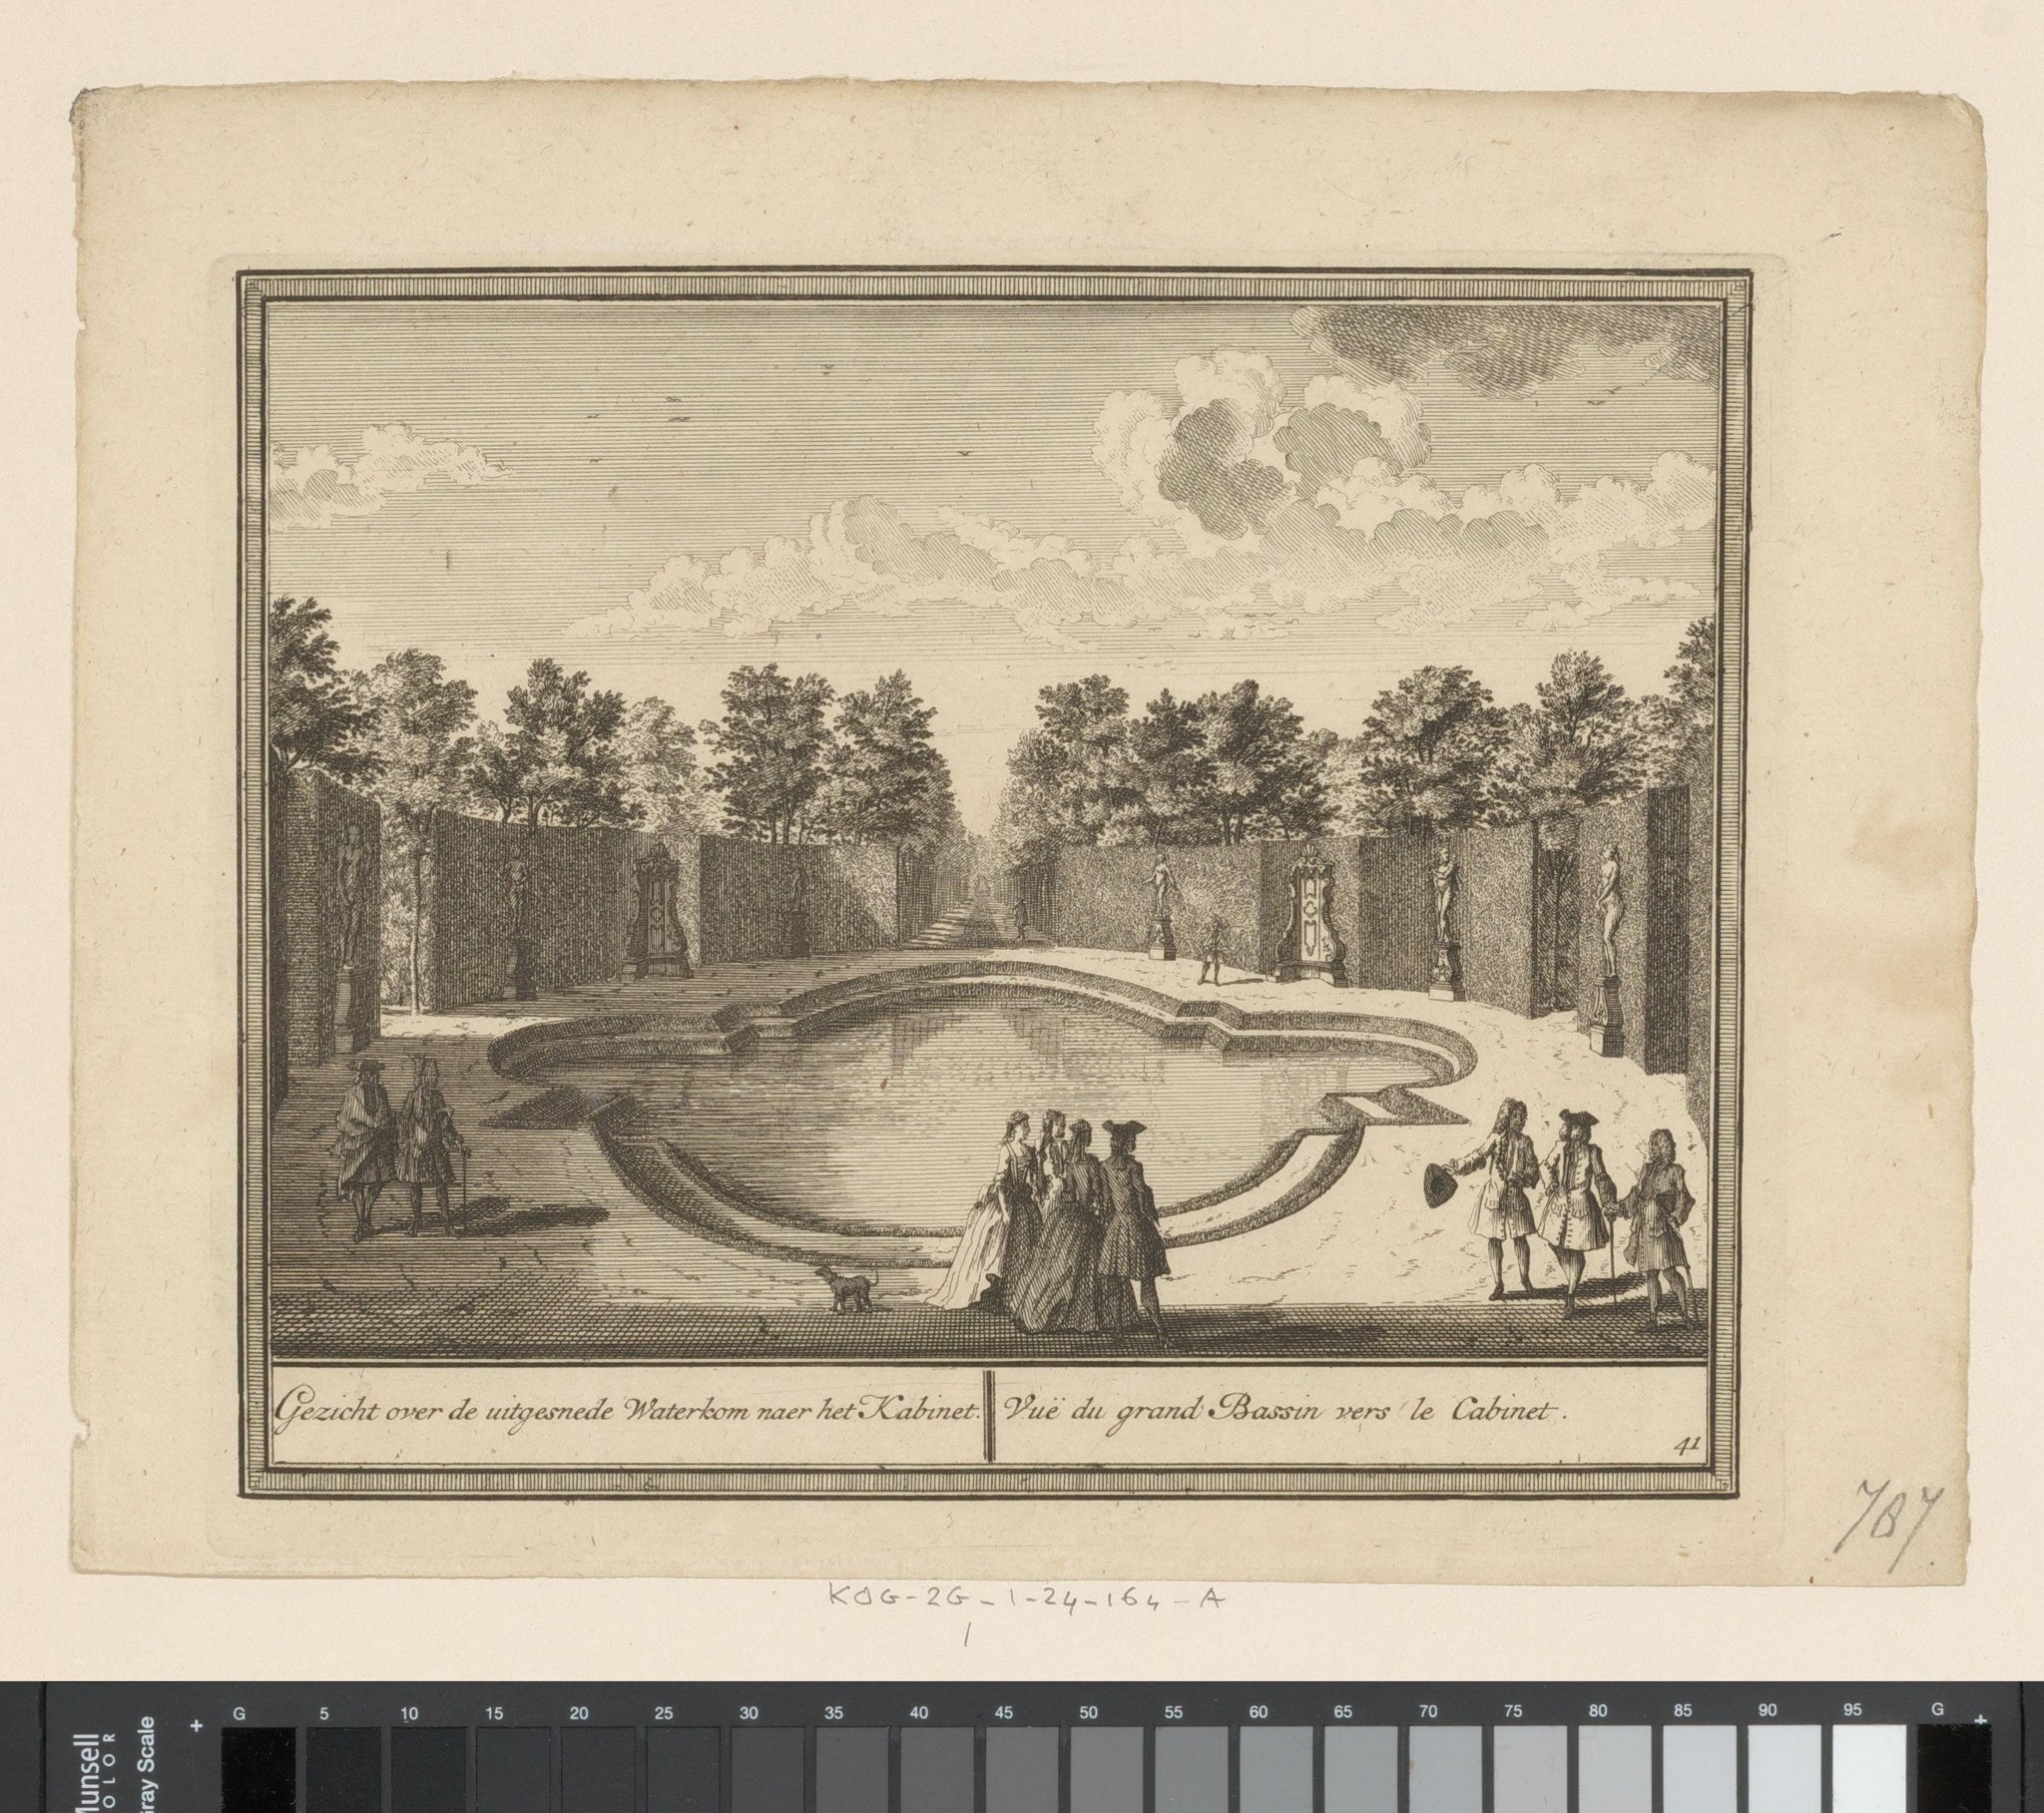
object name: print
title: Gezicht op de uitgesnede vijver van buitenplaats Watervliet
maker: hendrik de leth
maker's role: draughtsman, print maker, publisher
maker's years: 1703-1766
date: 1729-1732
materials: paper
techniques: engraving, etching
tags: garden pond, country-house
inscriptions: collector's mark: Lugt 1641, stamp, stamp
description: Prent mogelijk uit: Brouërius van Nidek, Matthaeus. Het zegepralend Kennemerland, vertoond in 100 heerlyke gezichten. Amsterdam: Jan Roman, s.a. Of uit: Brouërius van Nidek, Matthaeus. Het zegepralend Kennemerland, vertoond in veele heerlyke gezichten. Amsterdam: Andries en Hendrik de Leth, s.a [1729-1732].